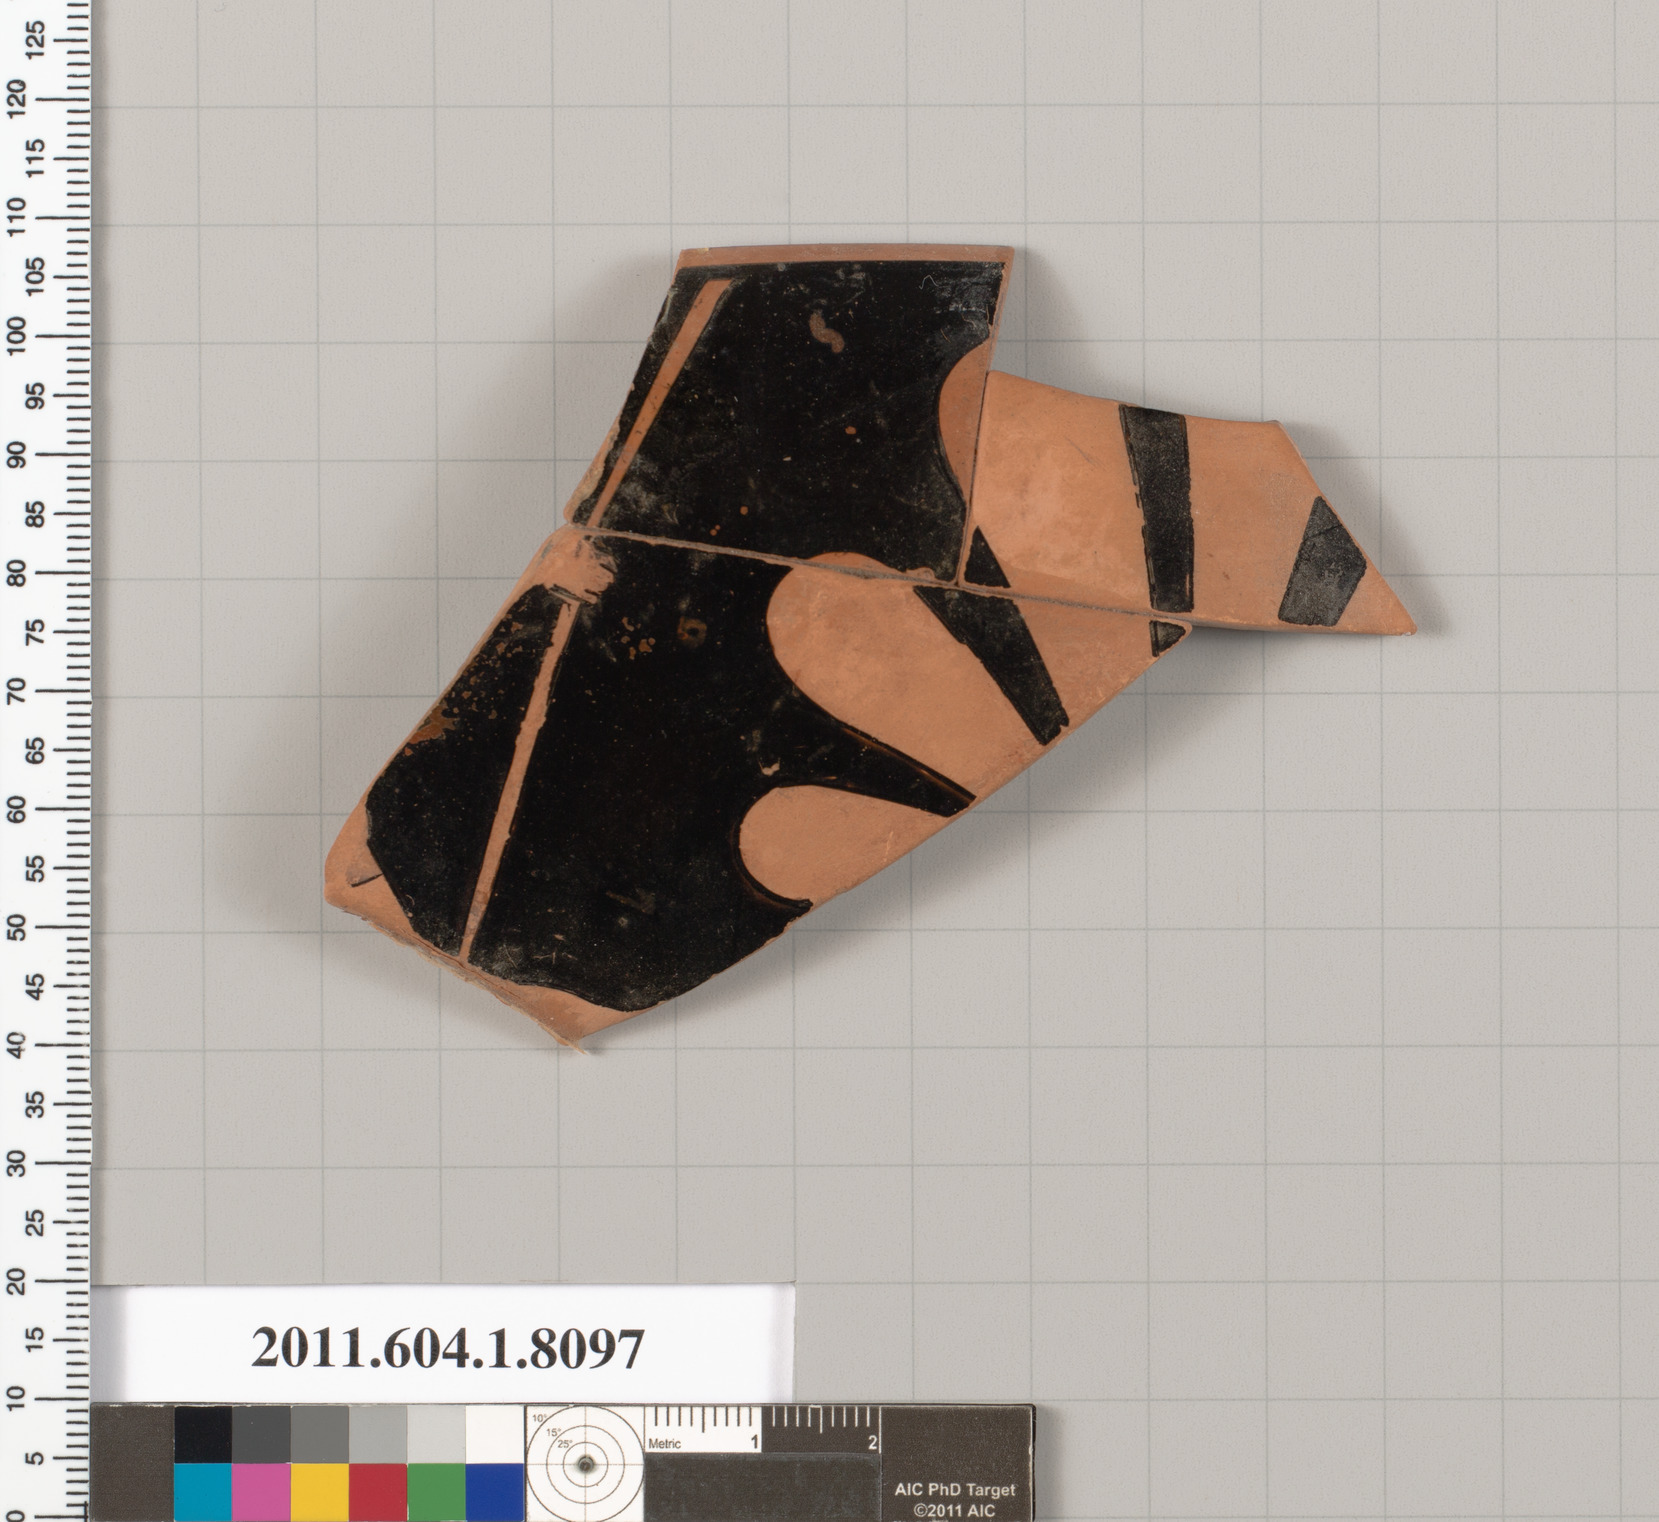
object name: kylix fragment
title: Terracotta rim fragment of a kylix (drinking cup)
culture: greek, attic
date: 520-510 BCE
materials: terracotta